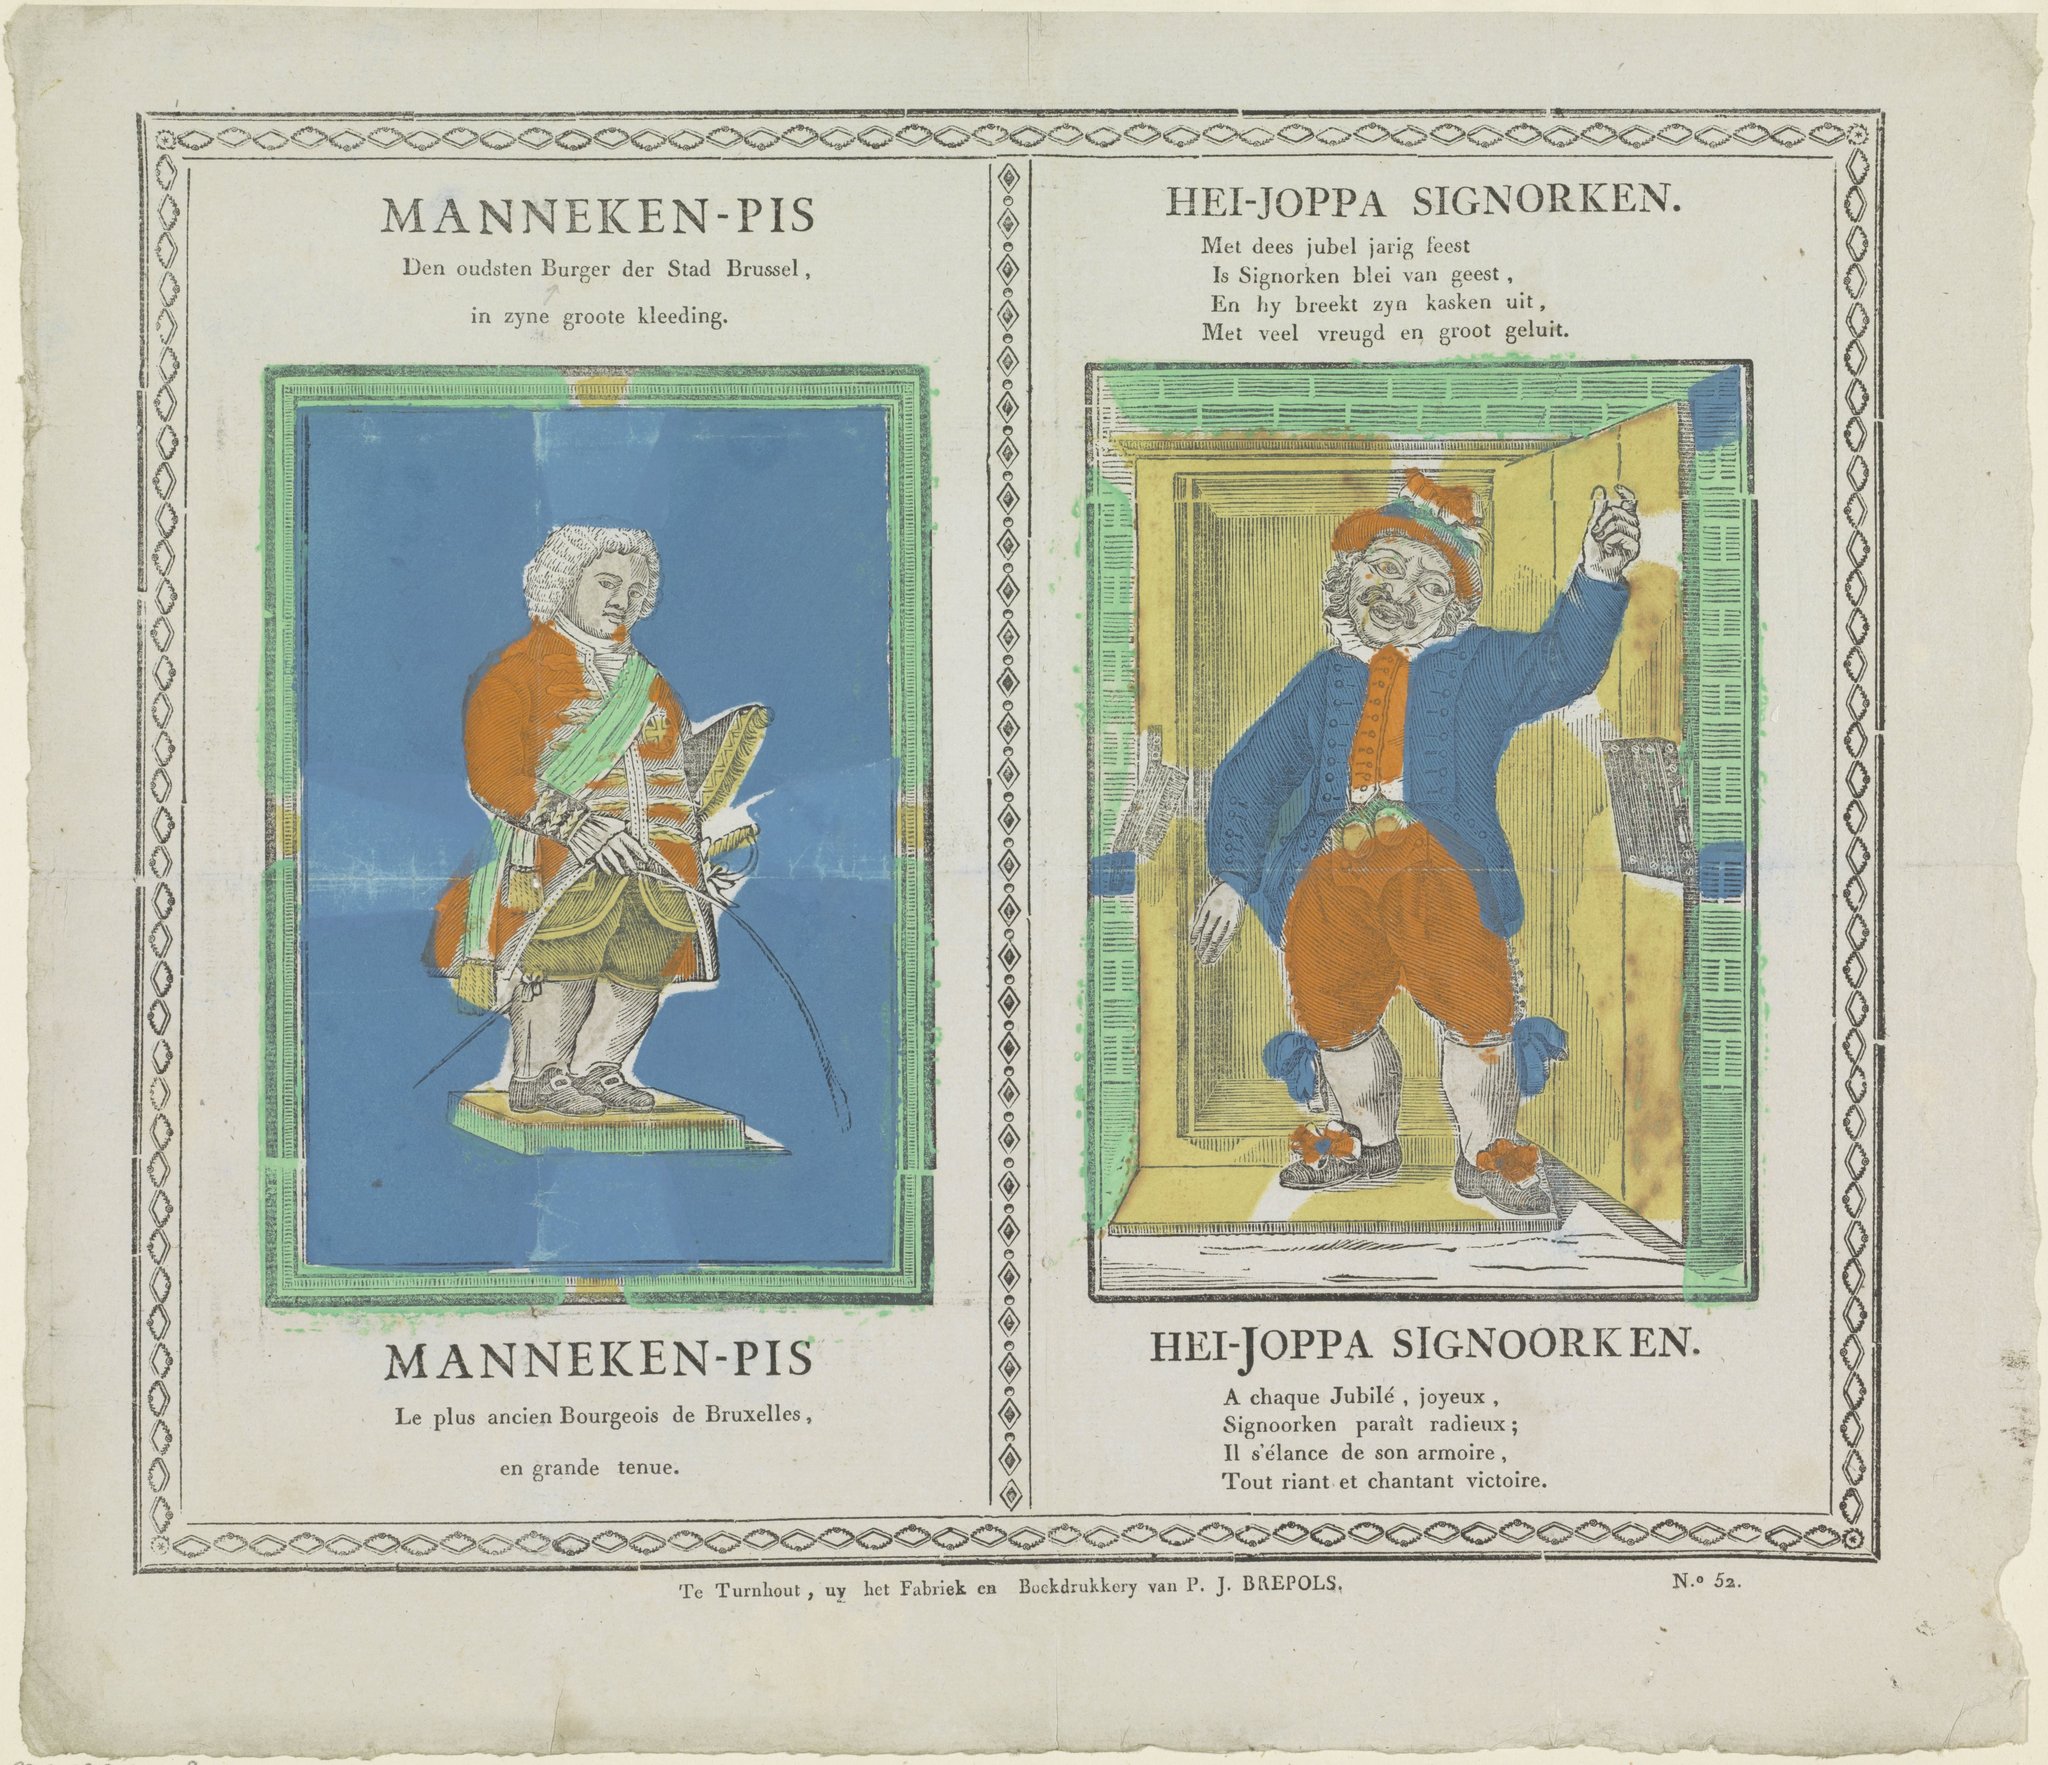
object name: print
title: Manneken-Pis / Hei-joppa signorken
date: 1800-1833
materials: paper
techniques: colour, letterpress printing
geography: turnhout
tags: piece of sculpture, reproduction of a piece of sculpture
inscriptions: collector's mark: Lugt 2760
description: Blad met 2 voorstellingen. Links Manneken Pis van Brussel met kleren aan, rechts Signorken. Bovenschriften in het Nederlands en onderschriften in het Frans. Geheel omgeven door een sierrand. Genummerd rechtsonder: No. 52.